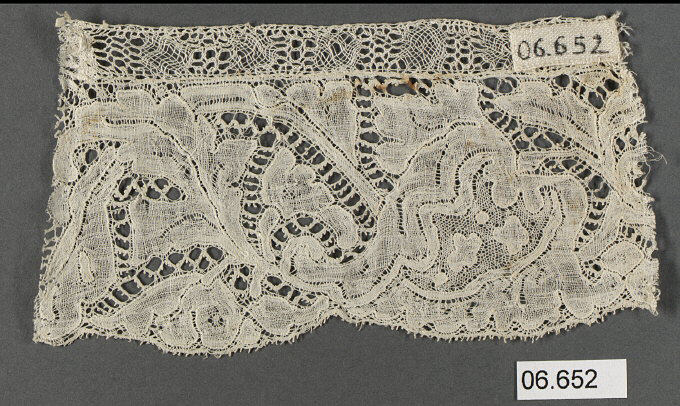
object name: fragment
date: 1701-1733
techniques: lace